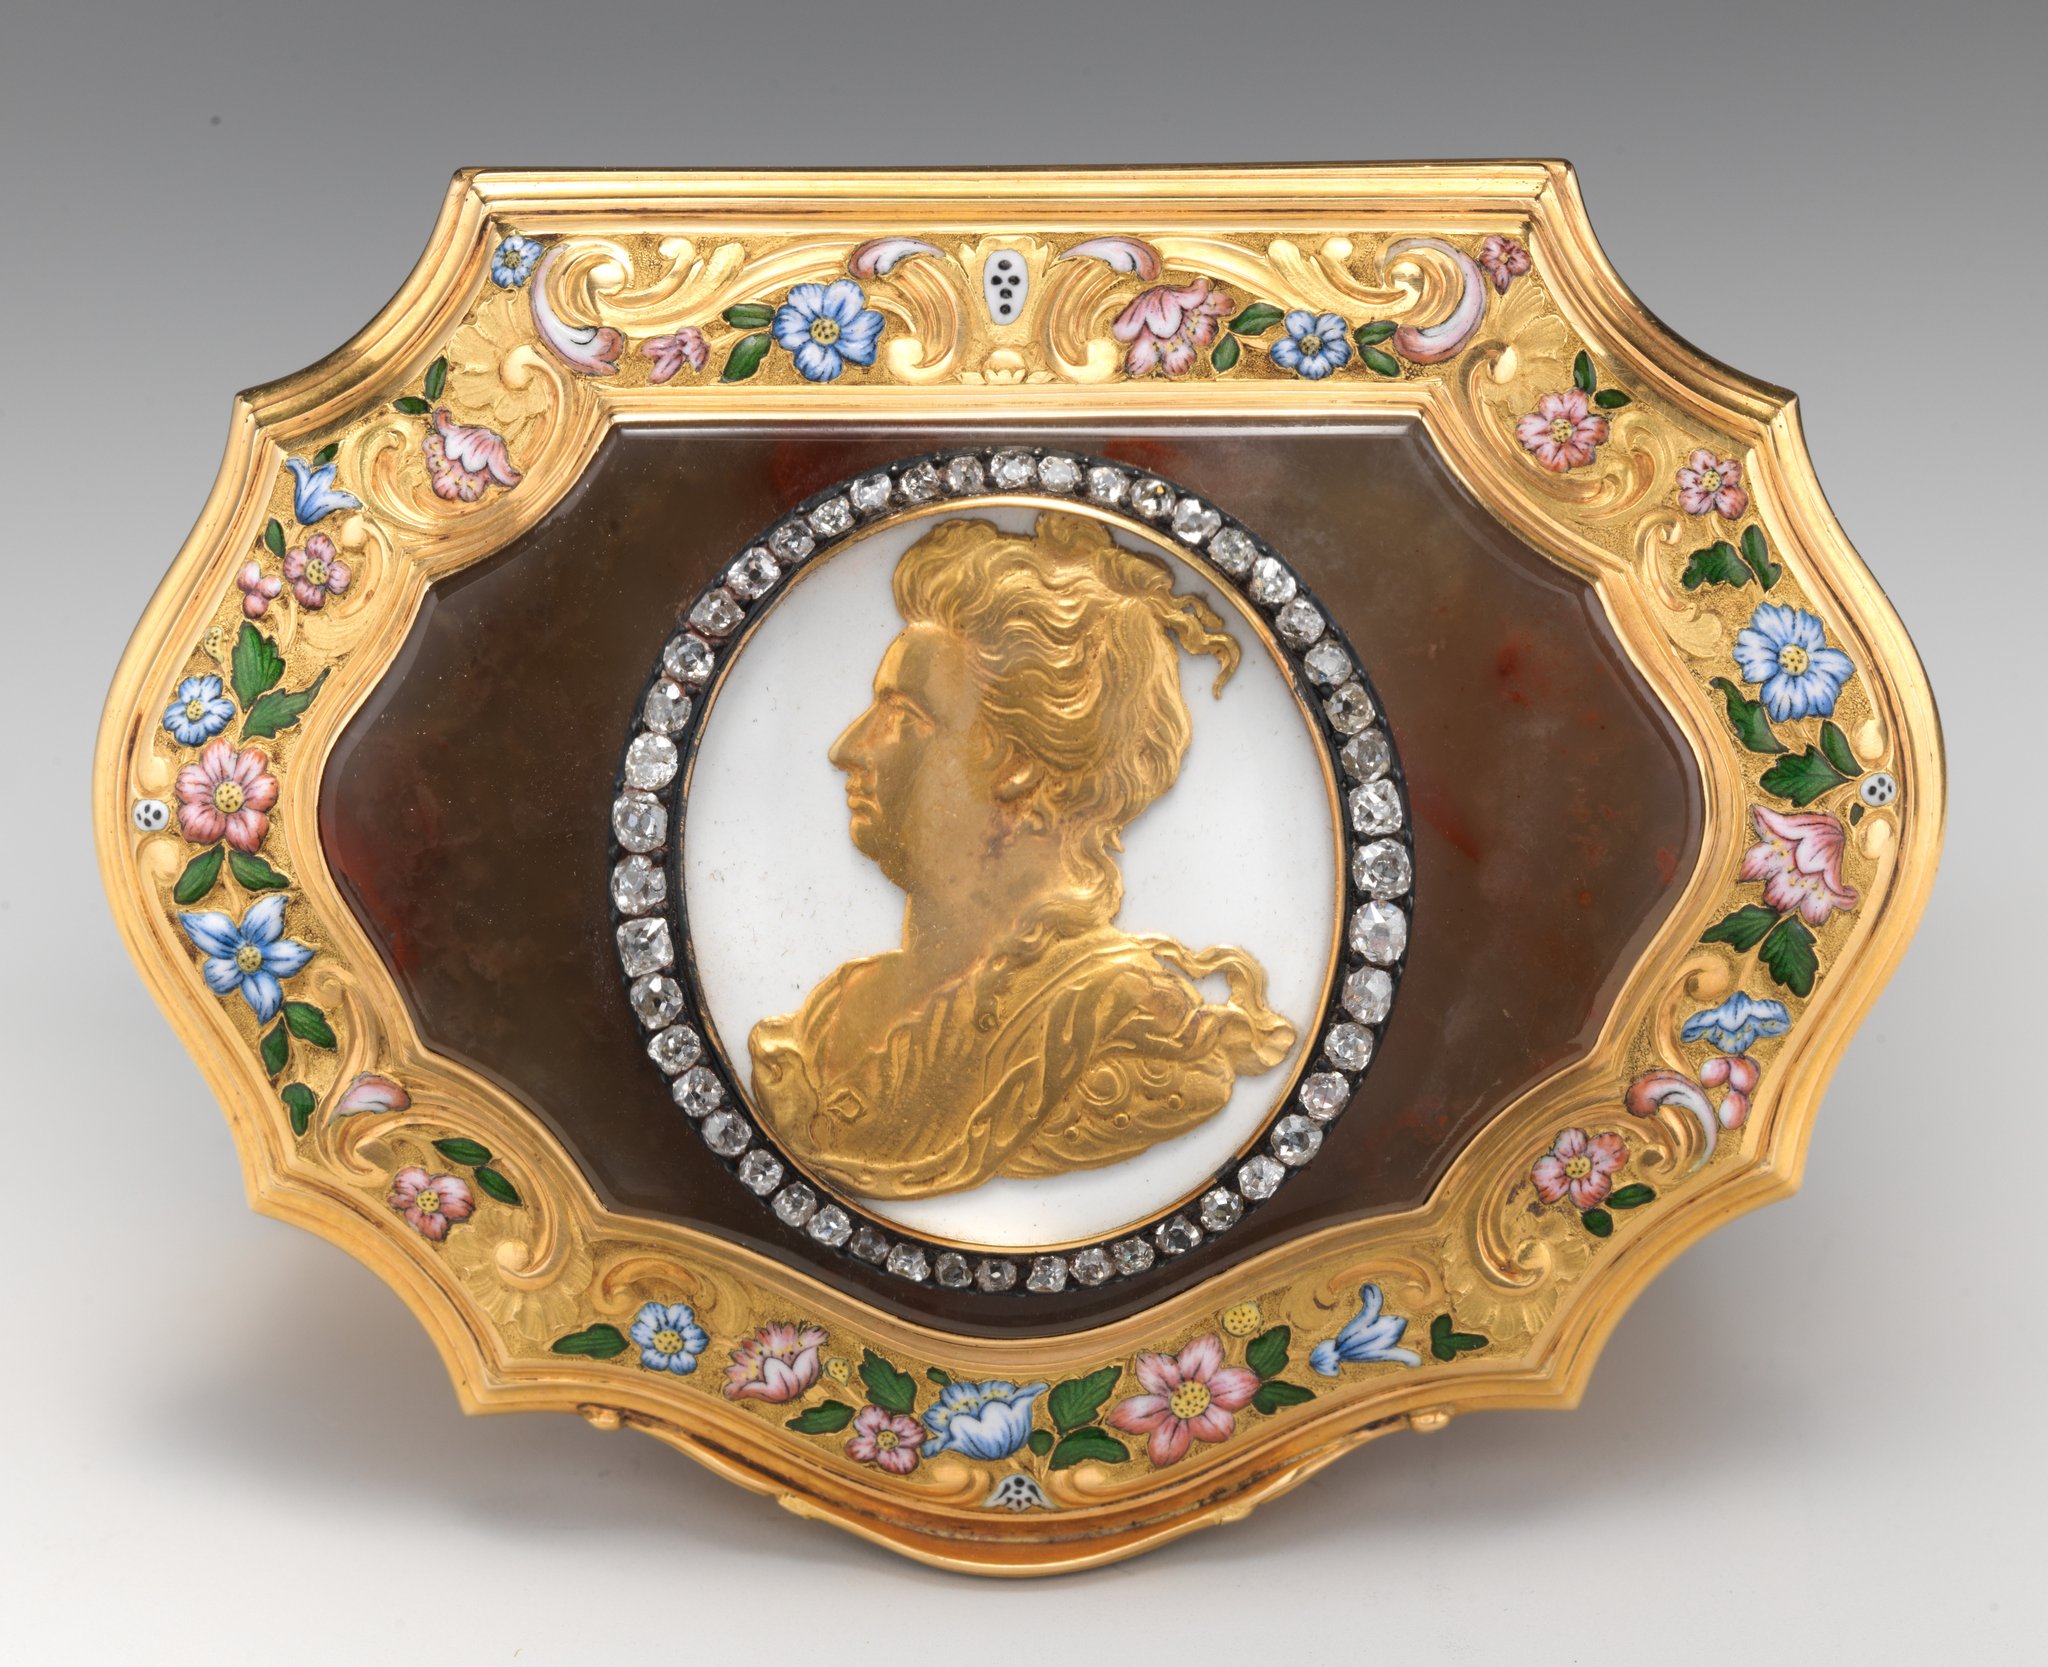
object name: snuffbox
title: Snuffbox with portrait of Queen Anne (1665-1714)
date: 1757-1758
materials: stone, diamond, enamel, gold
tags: human figures,profiles,flowers